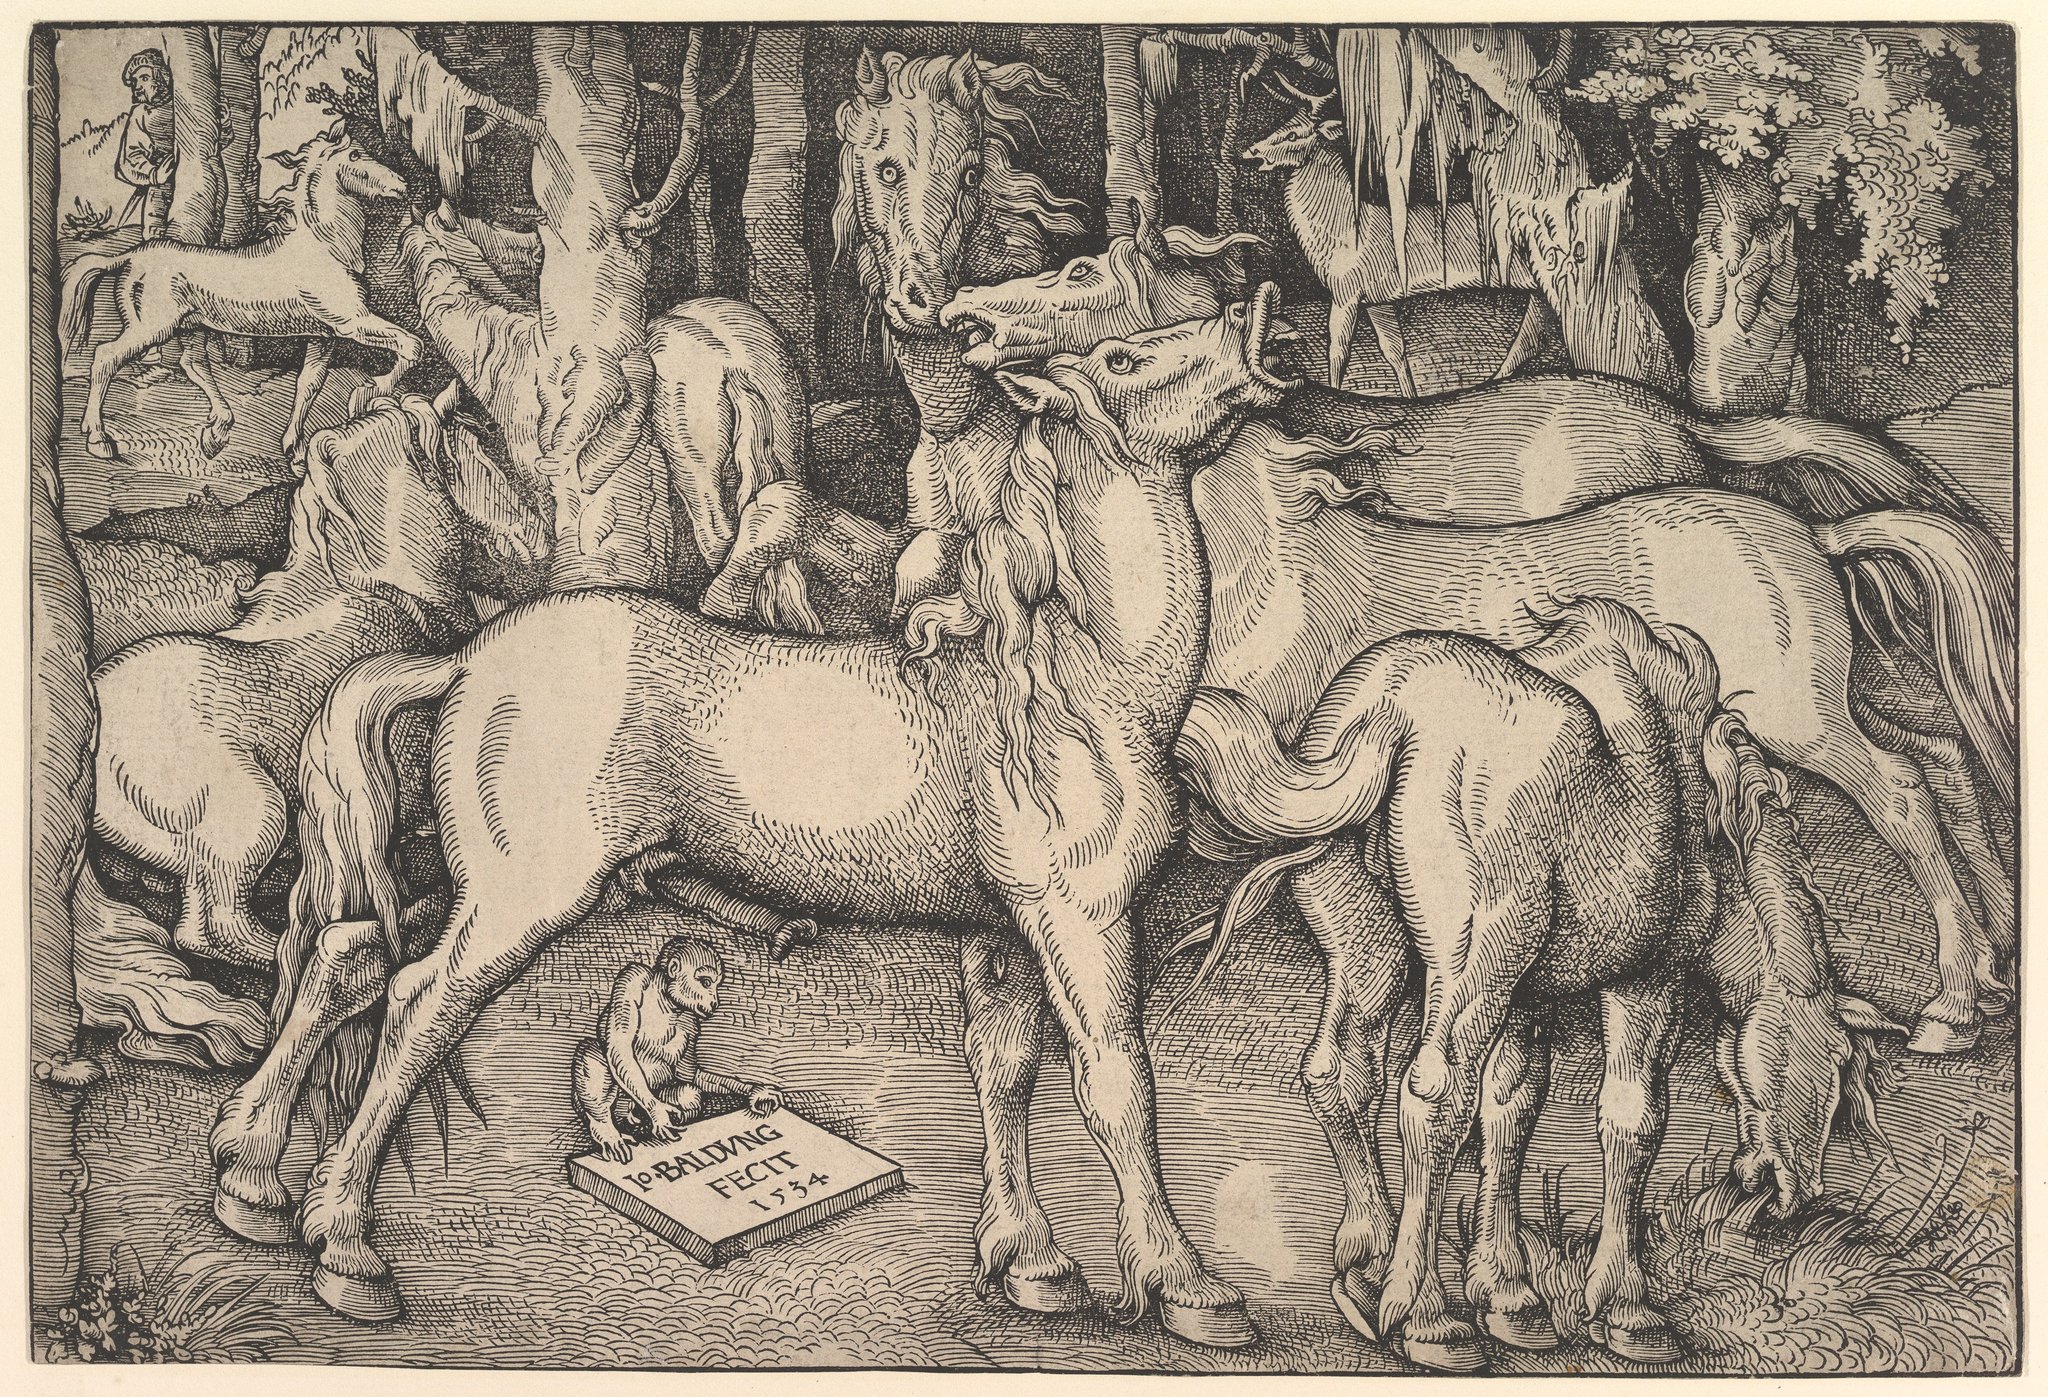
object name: print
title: Group of Seven Horses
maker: hans baldung (called hans baldung grien)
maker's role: artist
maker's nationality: german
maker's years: 1484-1545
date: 1534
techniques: woodcut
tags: horses,monkeys